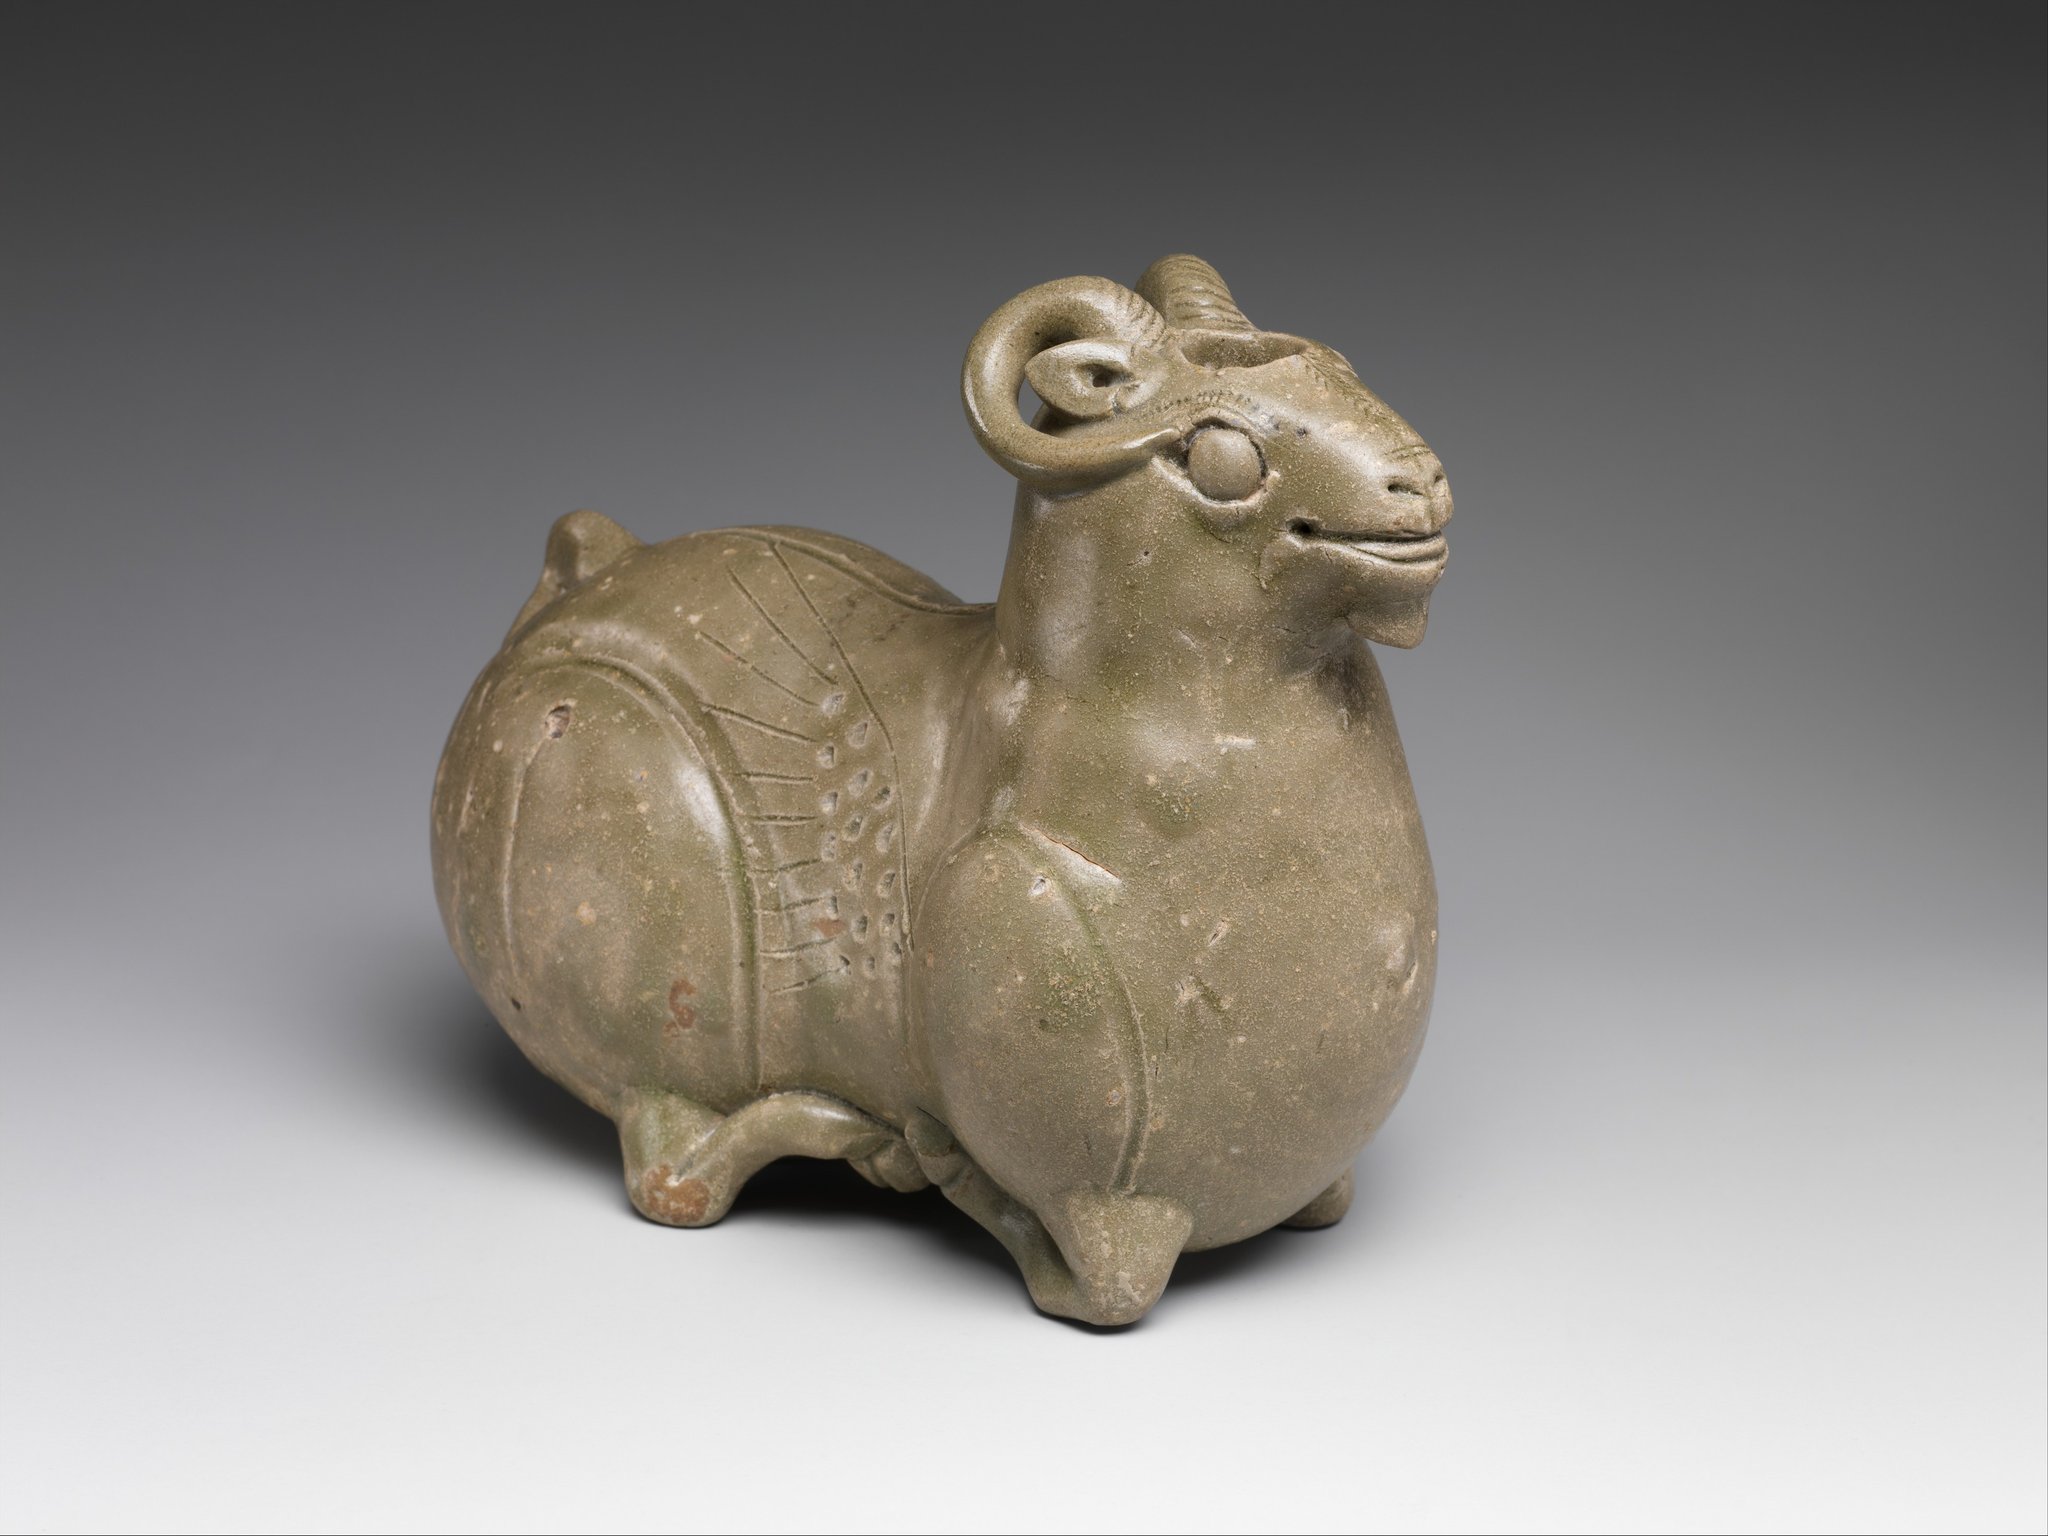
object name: vessel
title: Vessel in the shape of a kneeling ram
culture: chinese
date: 301-400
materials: ceramic glaze, glaze, stoneware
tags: rams